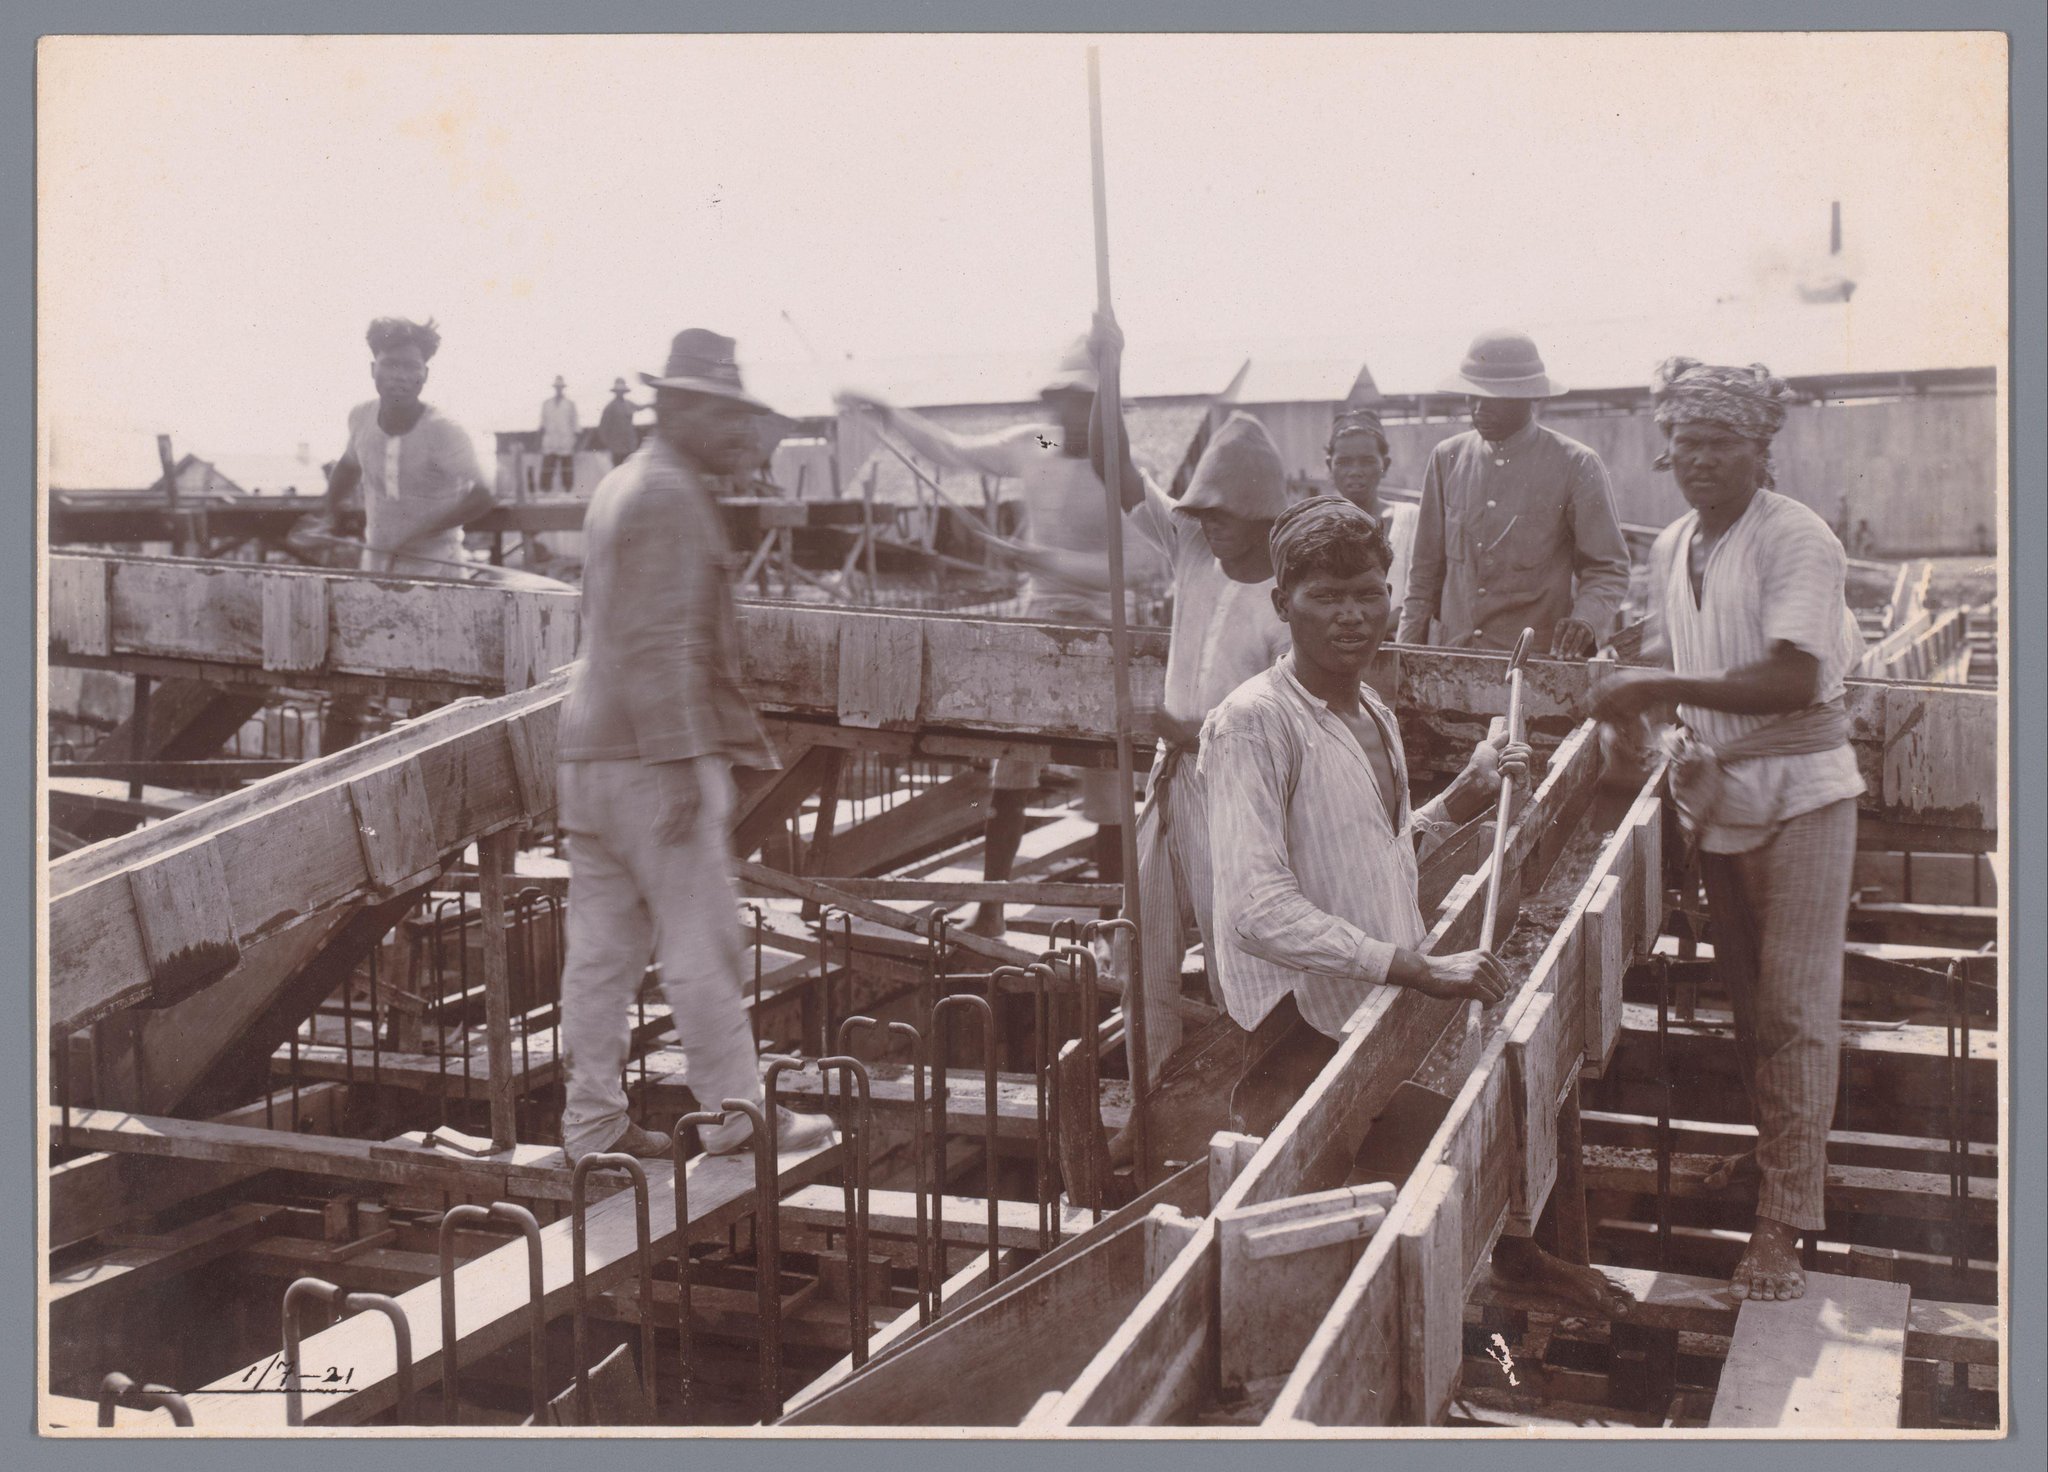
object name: photograph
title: Oceaanhaven Belawan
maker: Anonymous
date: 1921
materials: photographic support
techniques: gelatin silver print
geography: belawan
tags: harbour, building-site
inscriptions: date: ‘1/7-21’, inscription: ‘No. 40. Oceaanhaven Belawan / Betonstorting 2e & 3e opbouw 2e Caisson’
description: Storten van beton voor een caisson door Indonesische arbeiders, 1 juli 1921. Genummerd: 40. Onderdeel van de groep van losse foto's over de aanleg van de haven Belawan aan de kust voor Medan, Sumatra 1921-1922.